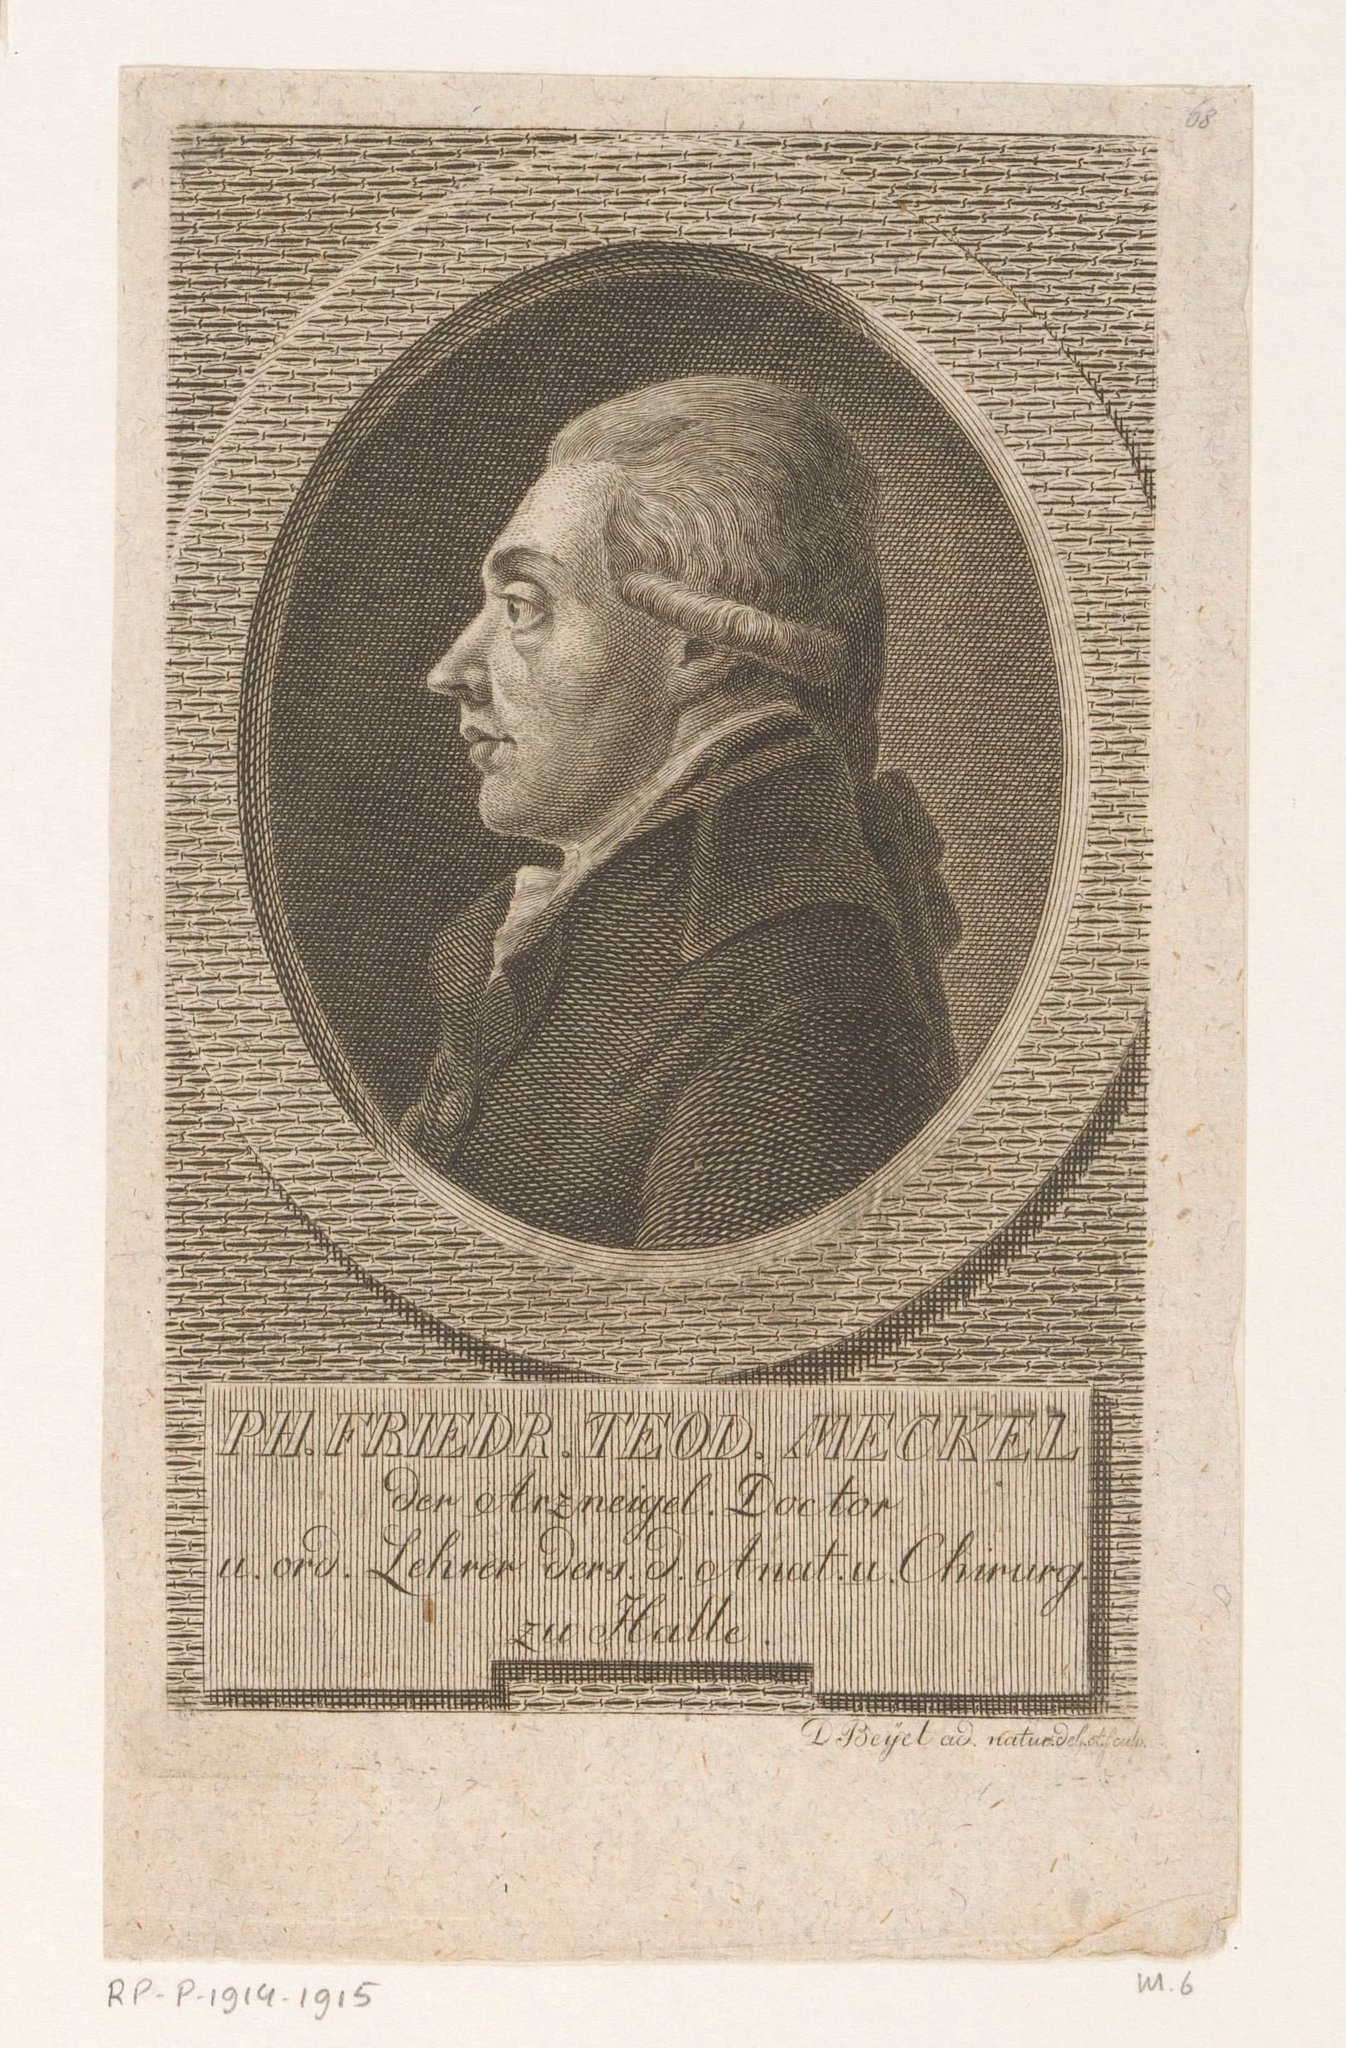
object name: print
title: Portret van Philipp Friedrich Theodor Meckel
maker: daniel beyel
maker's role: draughtsman, print maker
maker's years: 1760-1823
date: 1796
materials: paper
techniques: engraving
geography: halle an der saale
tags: berlin, historical persons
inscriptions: collector's mark: Lugt 2228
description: Prent ook gebruikt in: Neue Allgemeine deutsche Bibliothek. dl. 21, eerste stuk. Kiel: Carl Ernst Bohn, 1796.